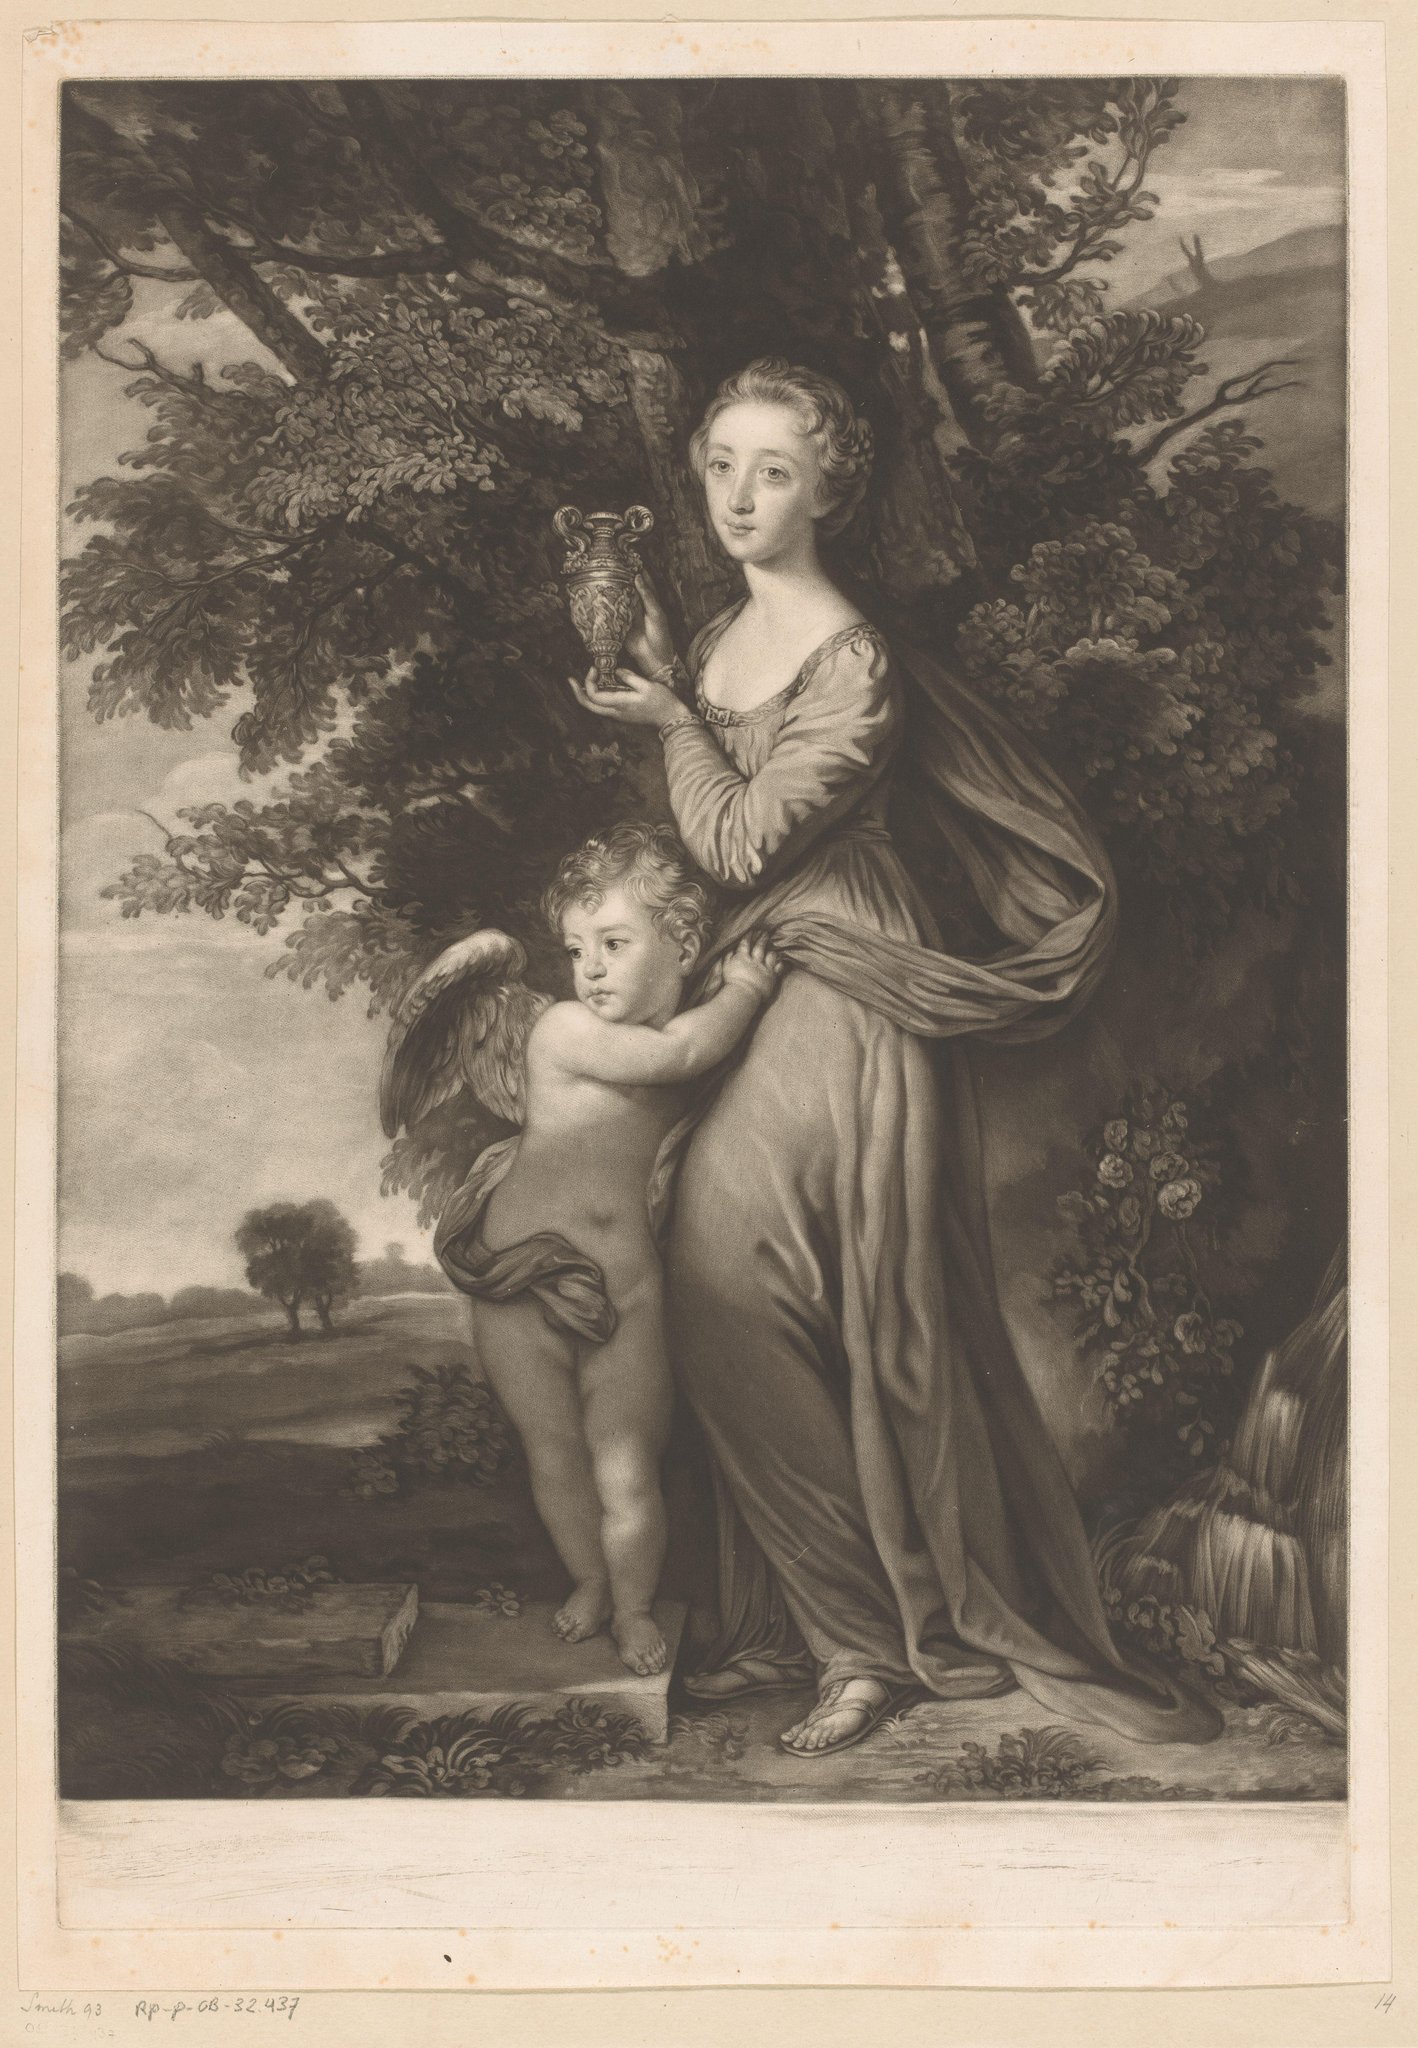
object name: print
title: Portret van Frances Anne Greville en Henry Francis Greville als Hebe en Cupido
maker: james mcardell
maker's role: print maker, publisher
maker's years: 1728-1765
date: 1762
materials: paper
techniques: mezzotint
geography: london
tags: historical person - woman - in a double portrait, (story of) hebe (juventas), (story of) cupid, amor (eros)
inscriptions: collector's mark: Lugt 240